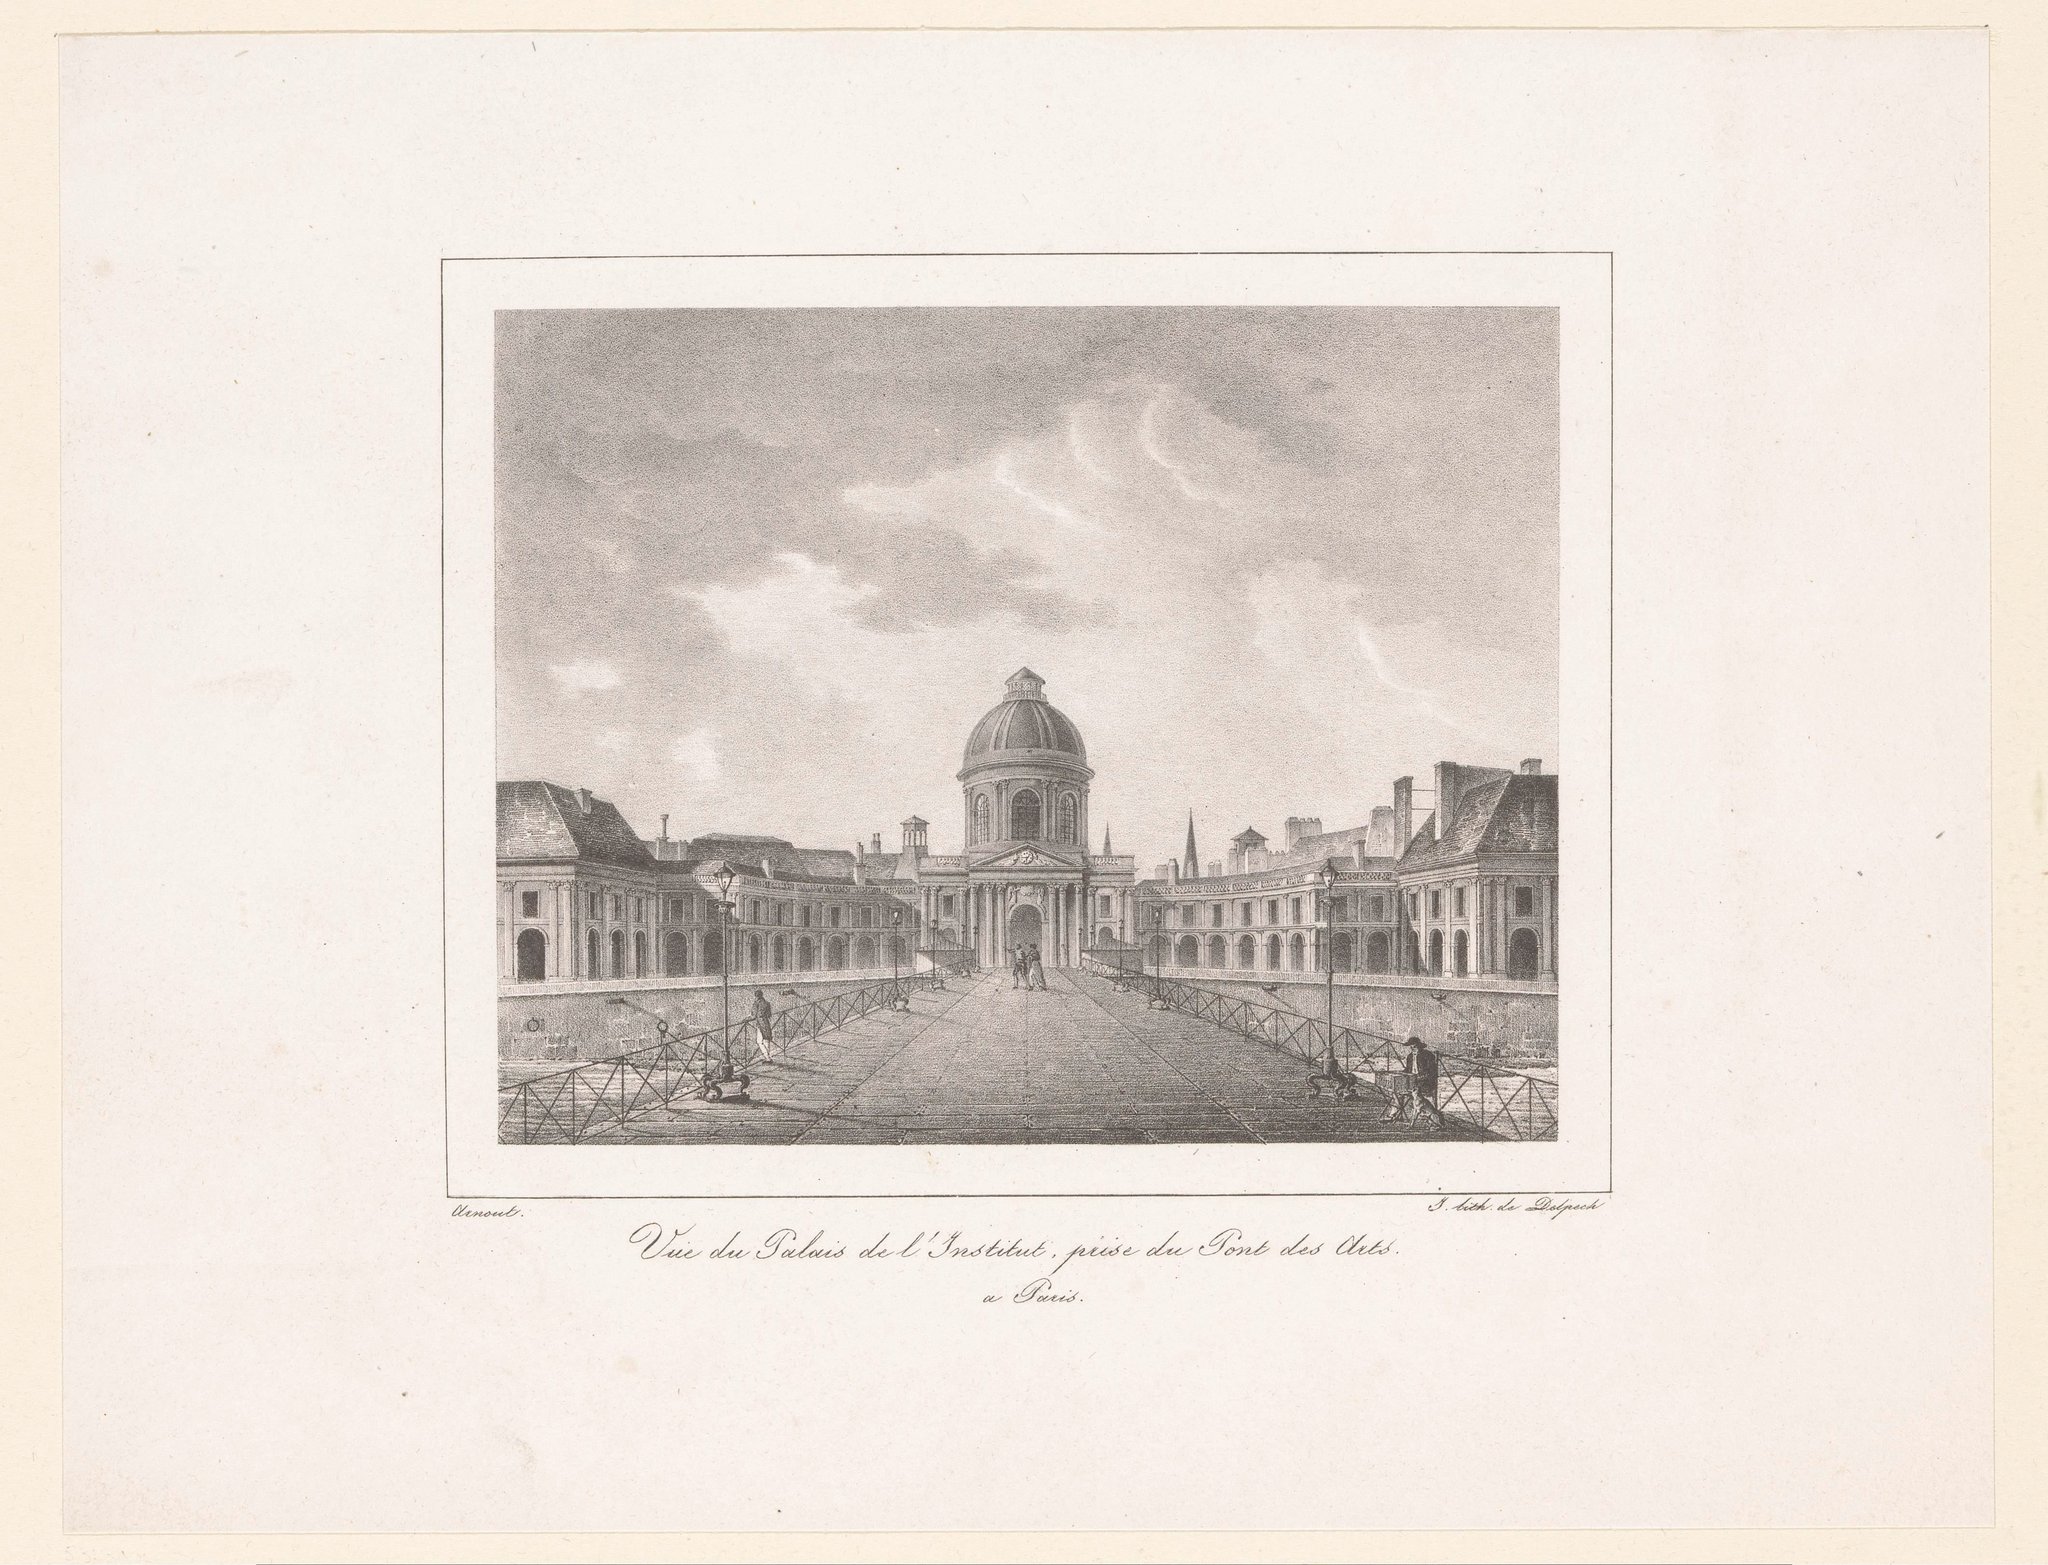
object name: print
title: Vue du palais de l'Institut, prise du pont des Arts à Paris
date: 1820-1821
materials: paper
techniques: lithograph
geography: paris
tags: learned society, academy of sciences, bridge in city across river, canal, etc., dome ~ architecture, place or institution of education and training of the artist, e.g.: academy of art, paris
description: De serie waar deze prent deel van uit maakt, bestaat waarschijnlijk uit dertig prenten.